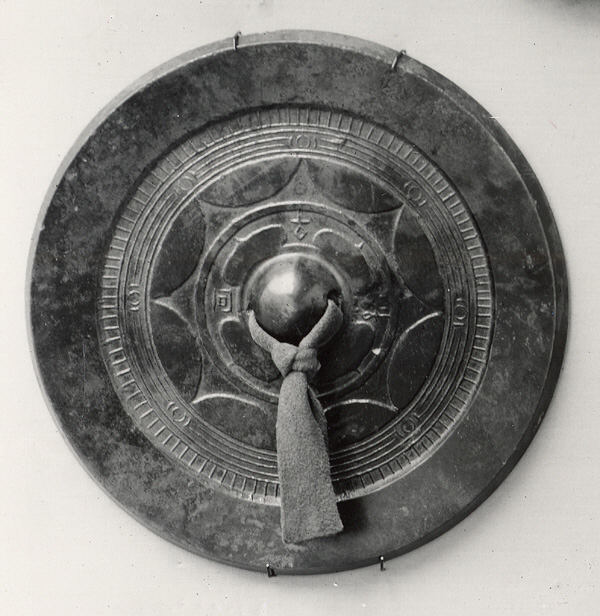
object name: mirror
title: Mirror with eight-point design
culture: chinese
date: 1-100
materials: bronze